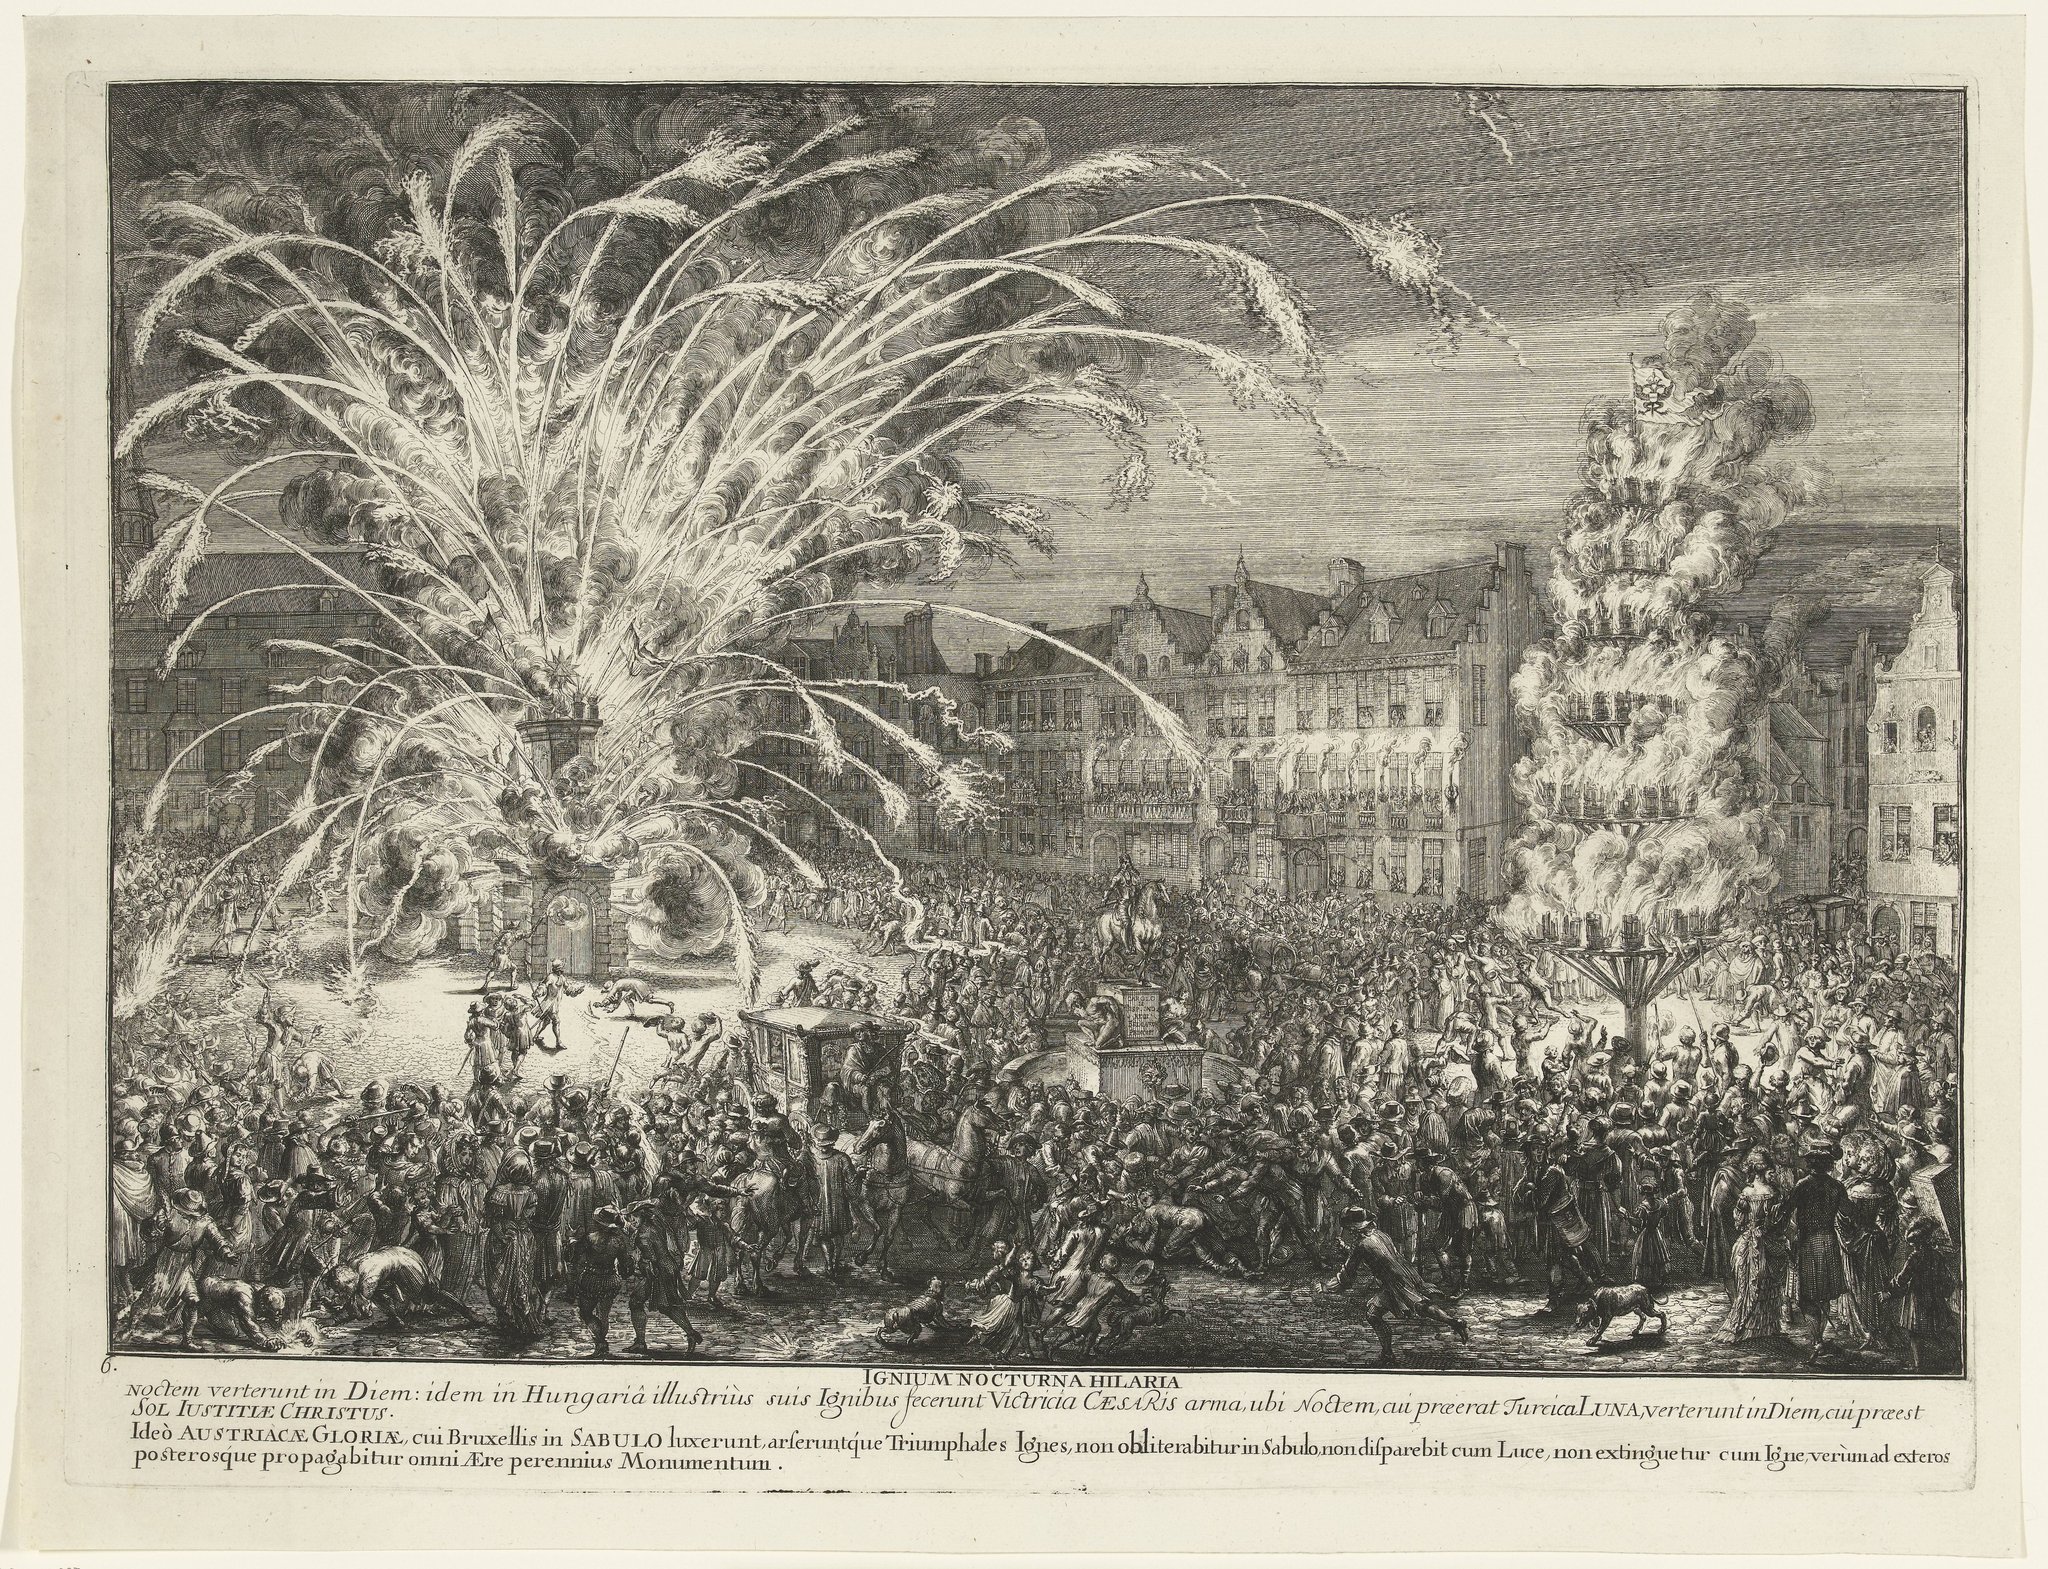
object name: print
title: Ignium nocturna hilaria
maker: romeyn de hooghe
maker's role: draughtsman, goldsmith, painter, print maker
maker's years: 1645-1708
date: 1686-1687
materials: paper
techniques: etching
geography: haarlem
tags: leopold i (keizer van duitsland), crowd, mob, triumphal entry and public reception, pageant, 'entrée solennelle', 'joyeuse entrée', festivities (+ illumination, fire-works ~ festive activities), brussels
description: Vuurwerk bij de intocht van Leopold I in Brussel, 1686. Op een bomvol plein bij de Onze-Lieve-Vrouw ten Zavel wordt vuurwerk afgestoken vanaf een paal rechts en een monument links. Midden op het voorplan rijdt een koets door de menigte.